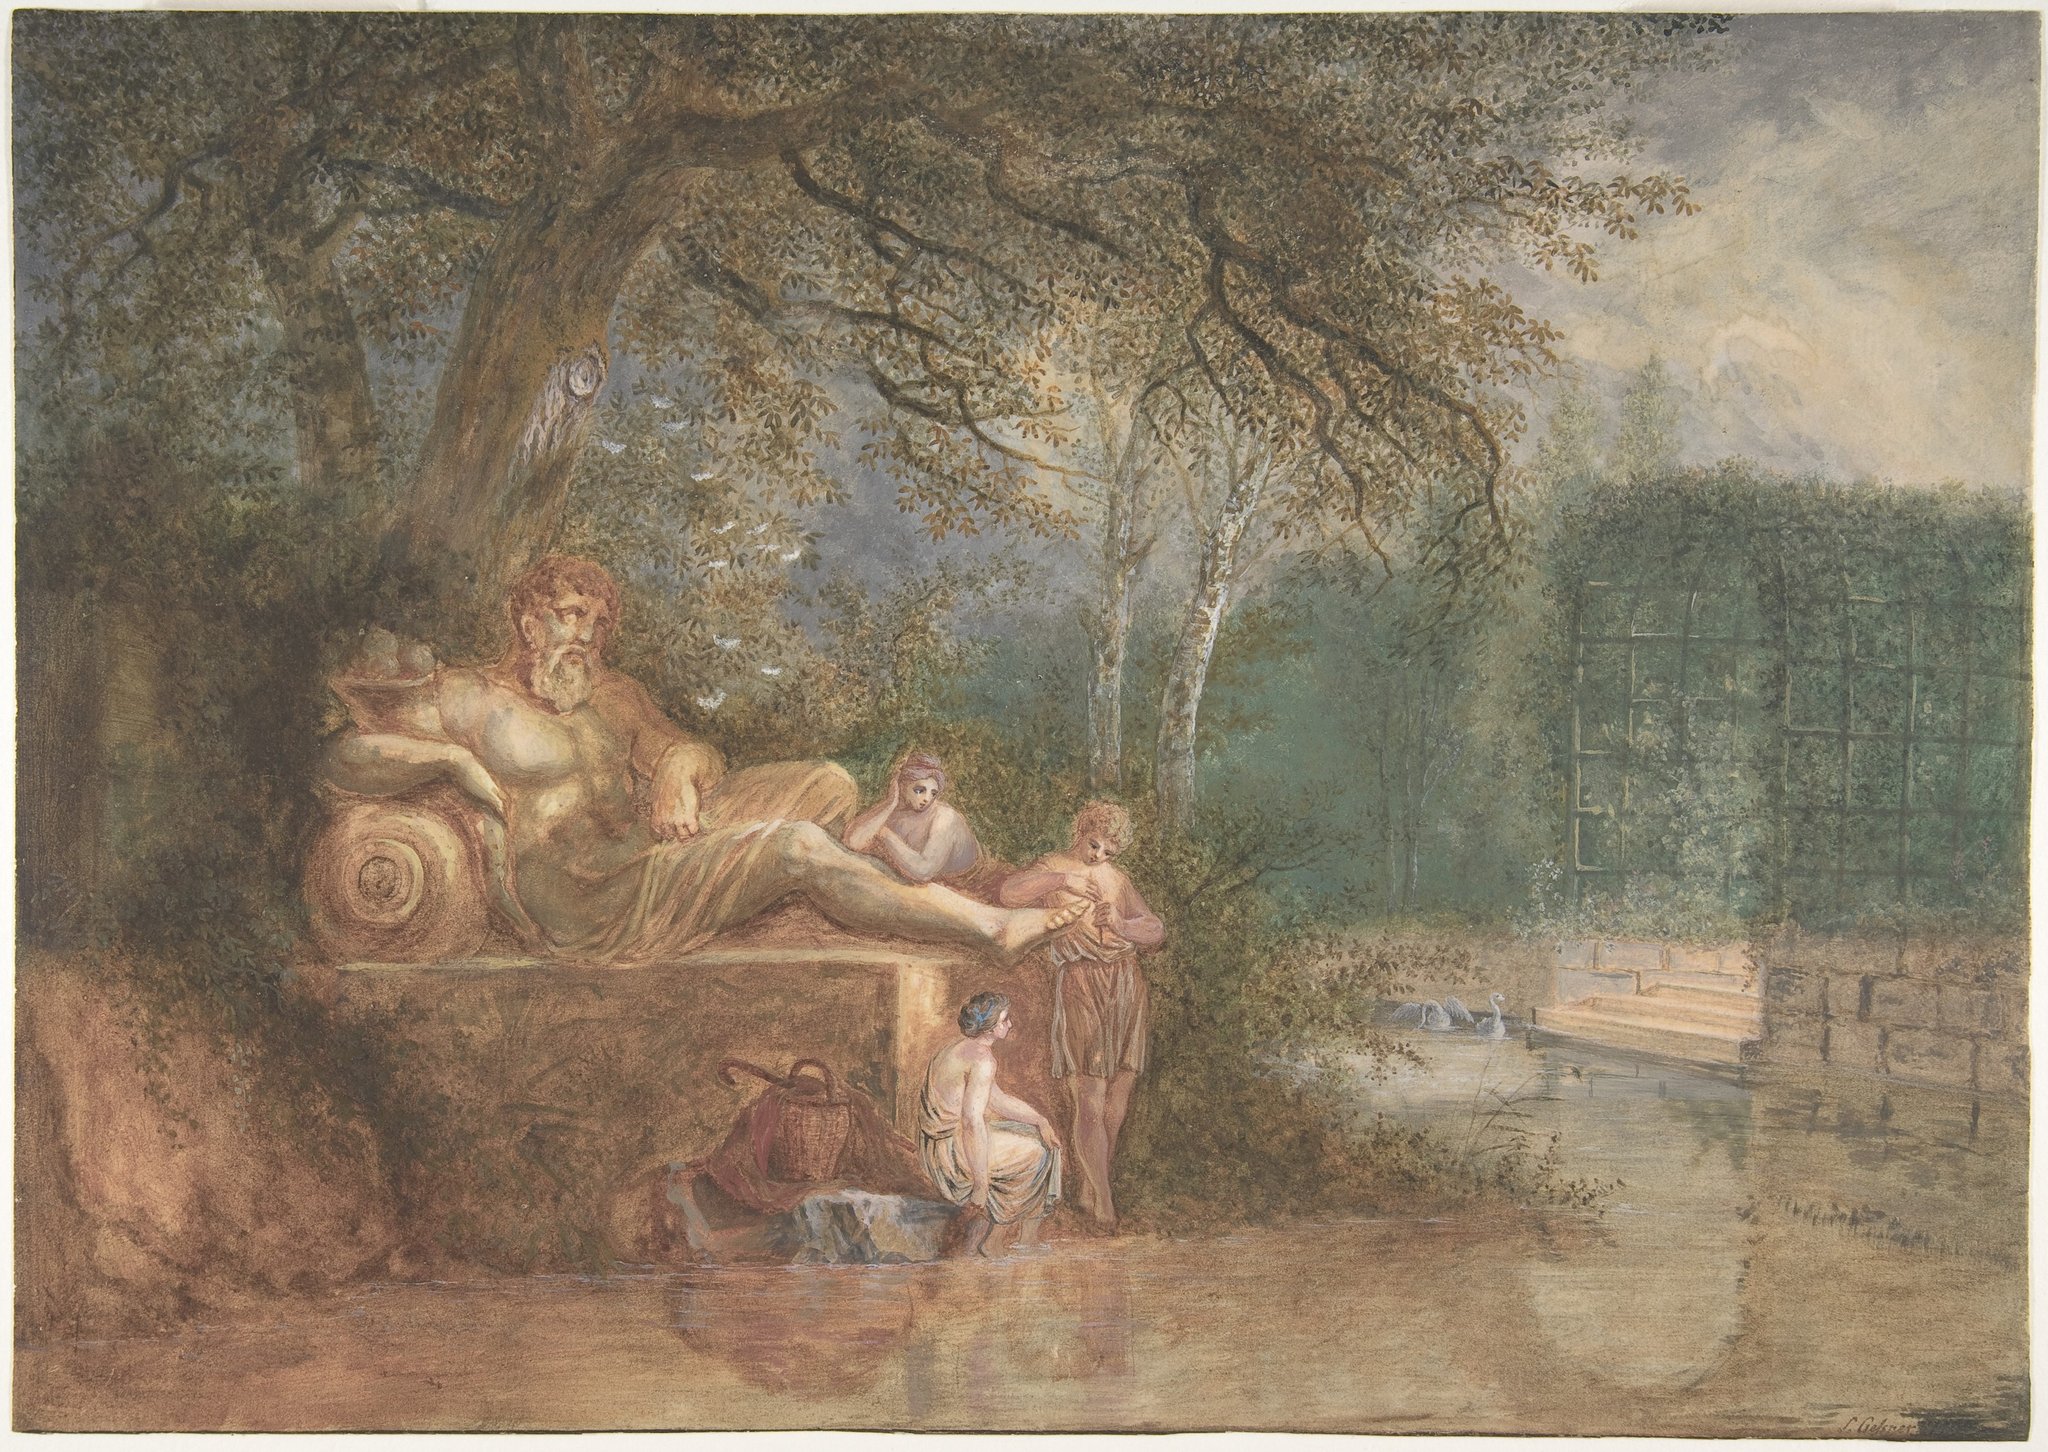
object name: drawing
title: A Park with Figures at a Statue near Water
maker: salomon gessner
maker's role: artist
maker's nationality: swiss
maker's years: 1730-1788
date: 1775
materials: gouache, ink, watercolor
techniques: pen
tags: sculpture,women